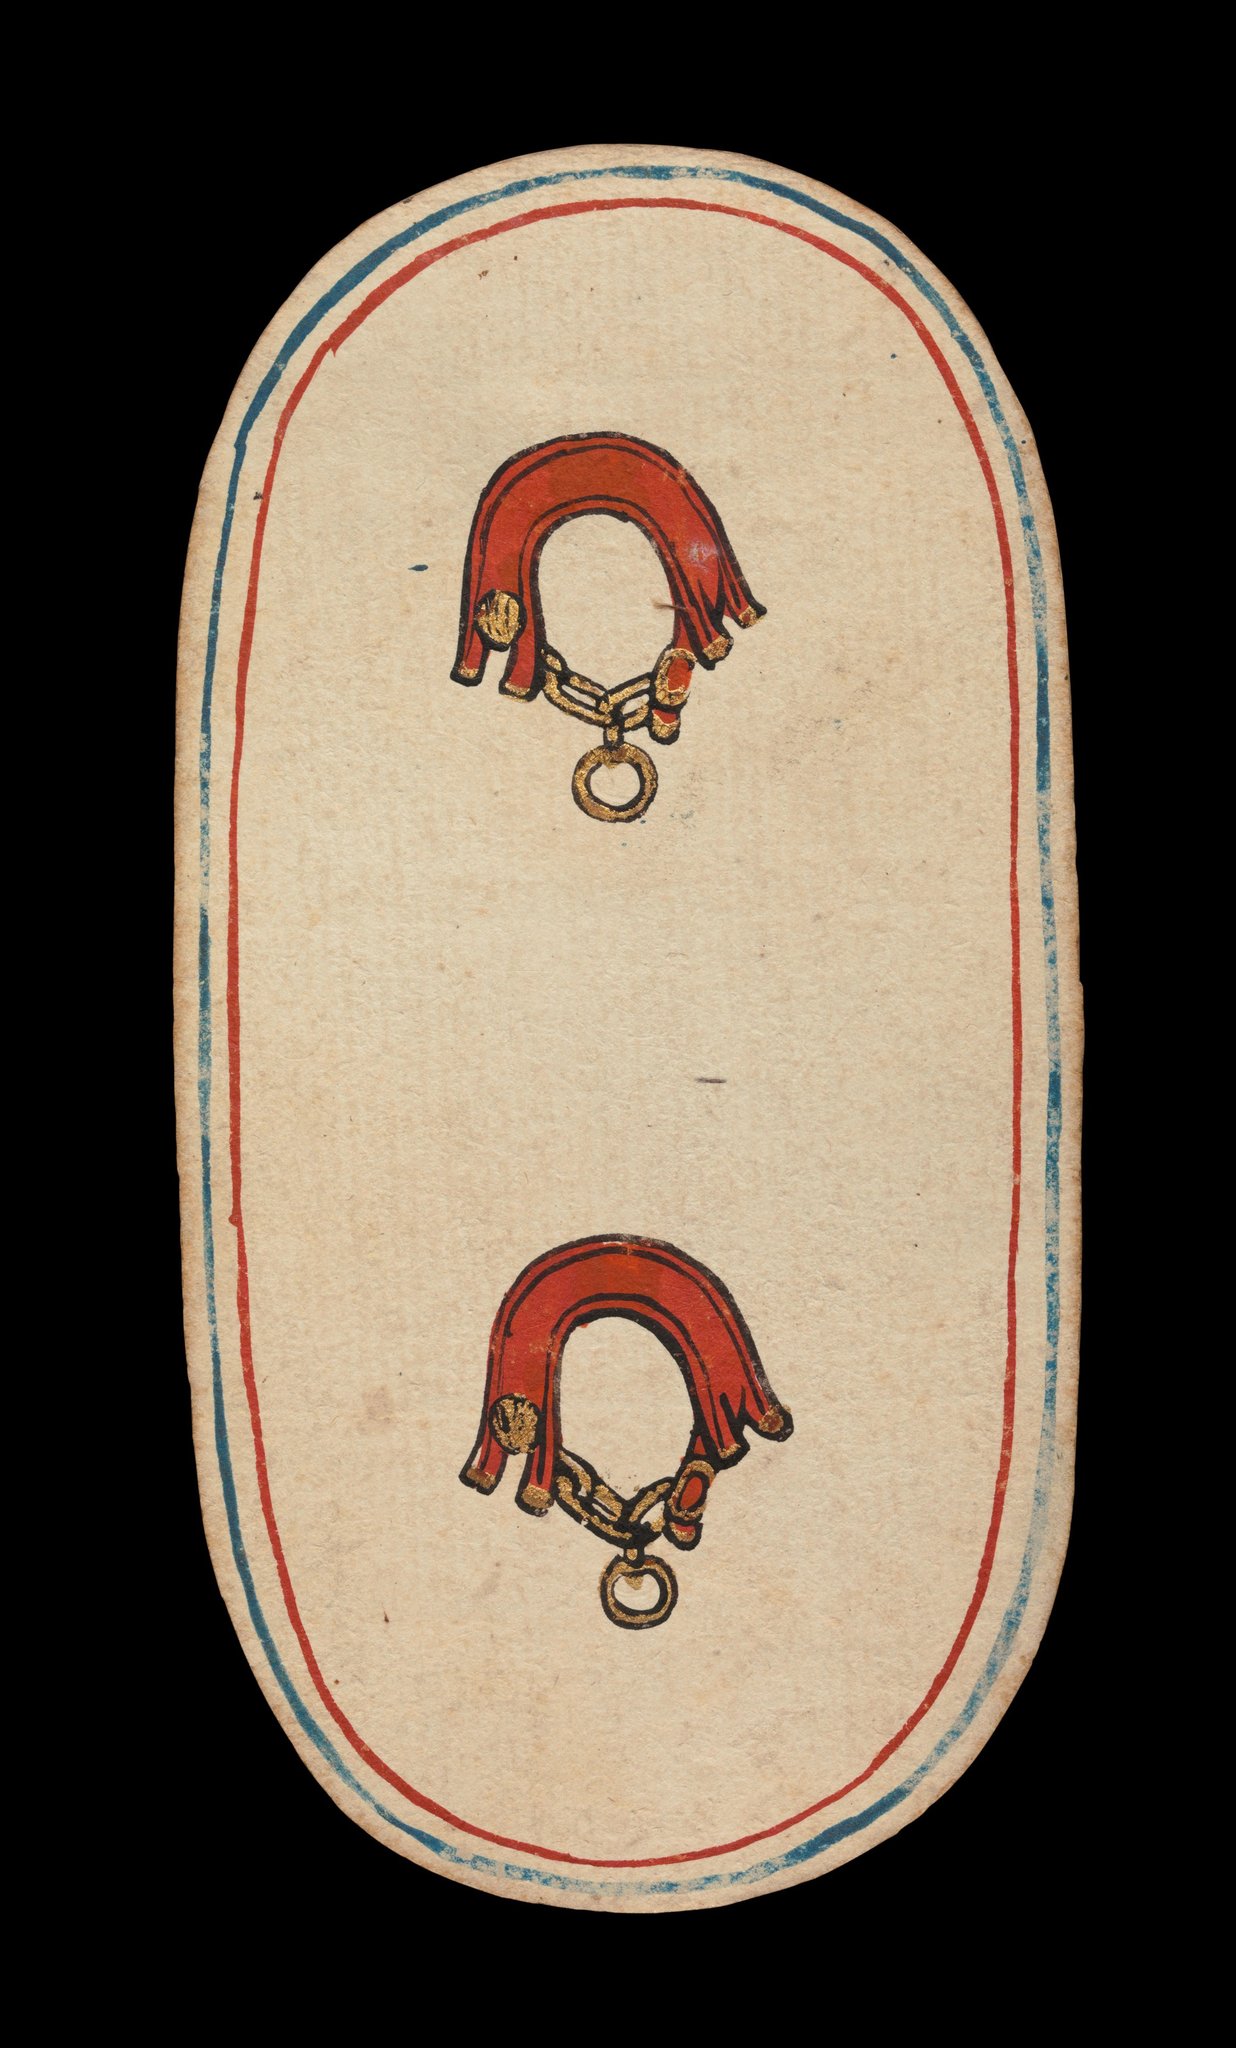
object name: playing card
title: 2 of Collars, from The Cloisters Playing Cards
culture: south netherlandish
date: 1475-1480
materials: glaze, gold, ink, paint, paper, silver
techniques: pen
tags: playing cards,games